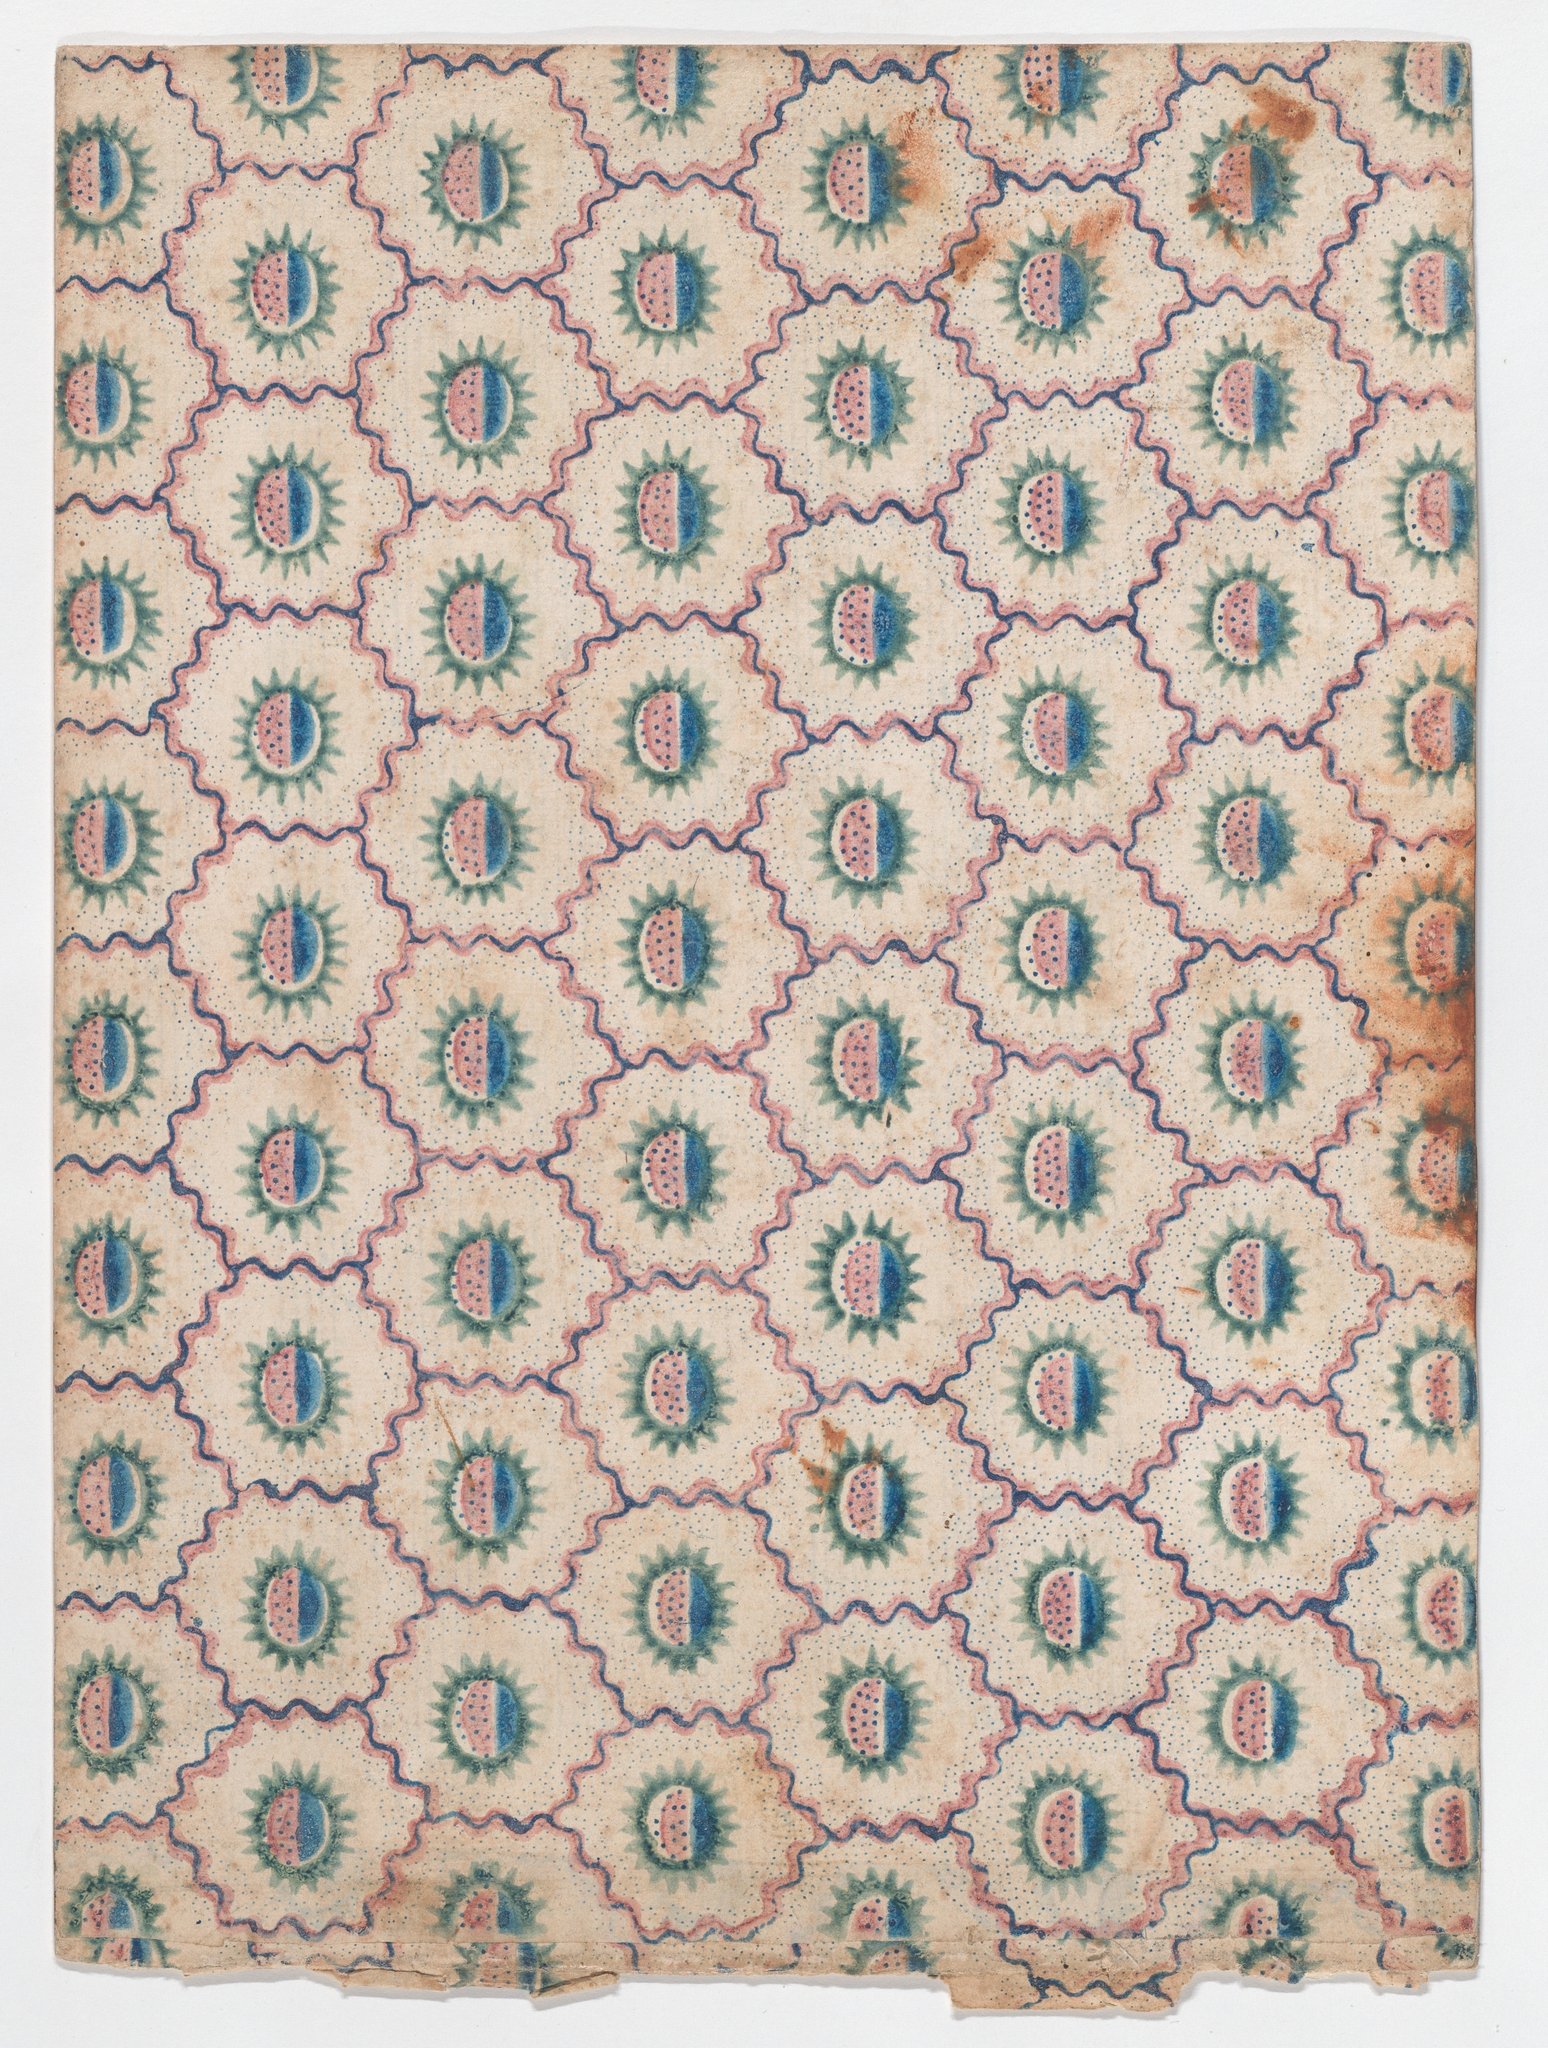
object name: print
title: Sheet with abstract pattern with curved lines and dots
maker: Anonymous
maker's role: artist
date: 1801-1900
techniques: relief print